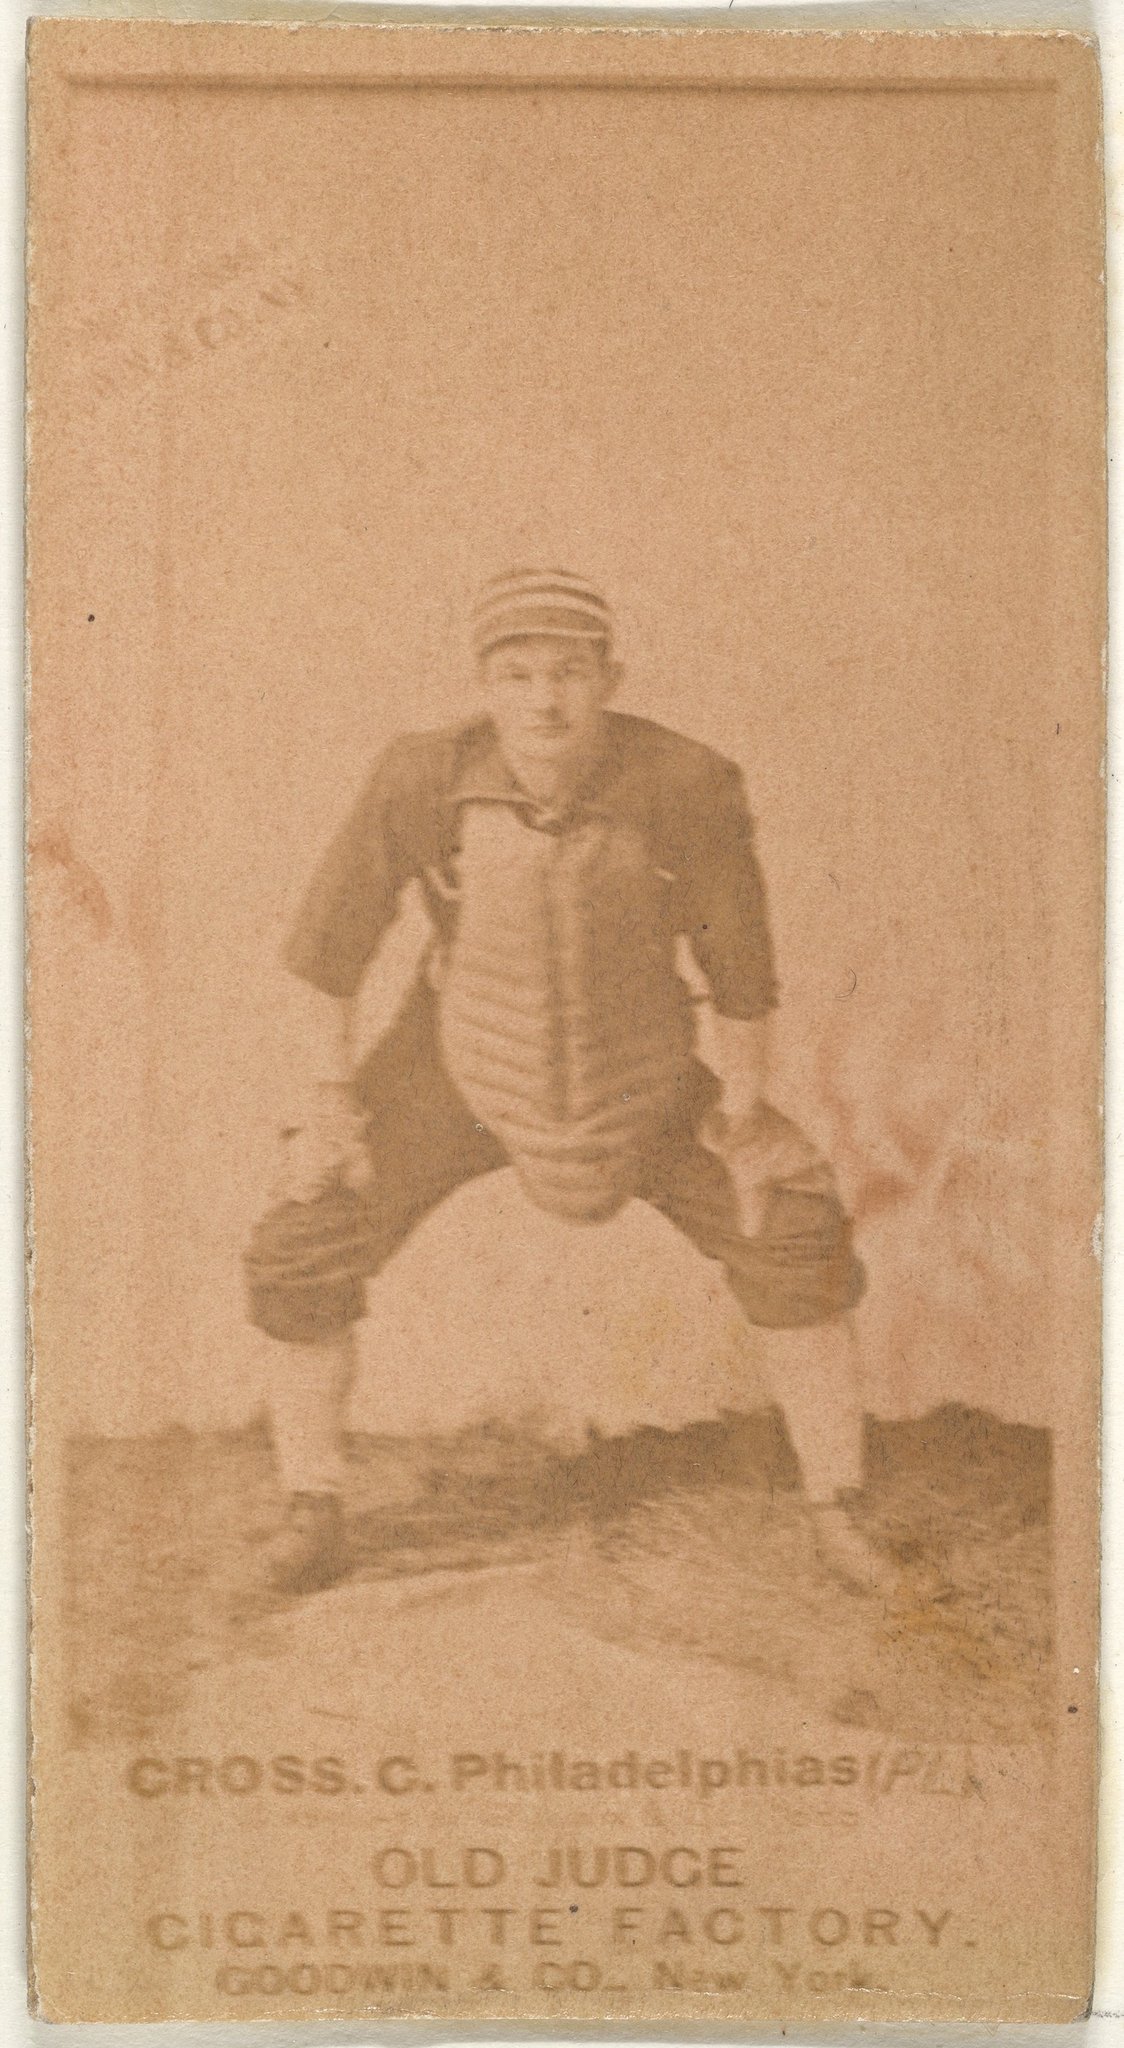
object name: baseball card, photograph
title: Lafayette "Lave" Napoleon Cross, Catcher, Philadelphia, from the Old Judge series (N172) for Old Judge Cigarettes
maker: goodwin & company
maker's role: publisher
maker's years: 1850-1950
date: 1887-1890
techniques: albumen silver print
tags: men,portraits,baseball,athletes